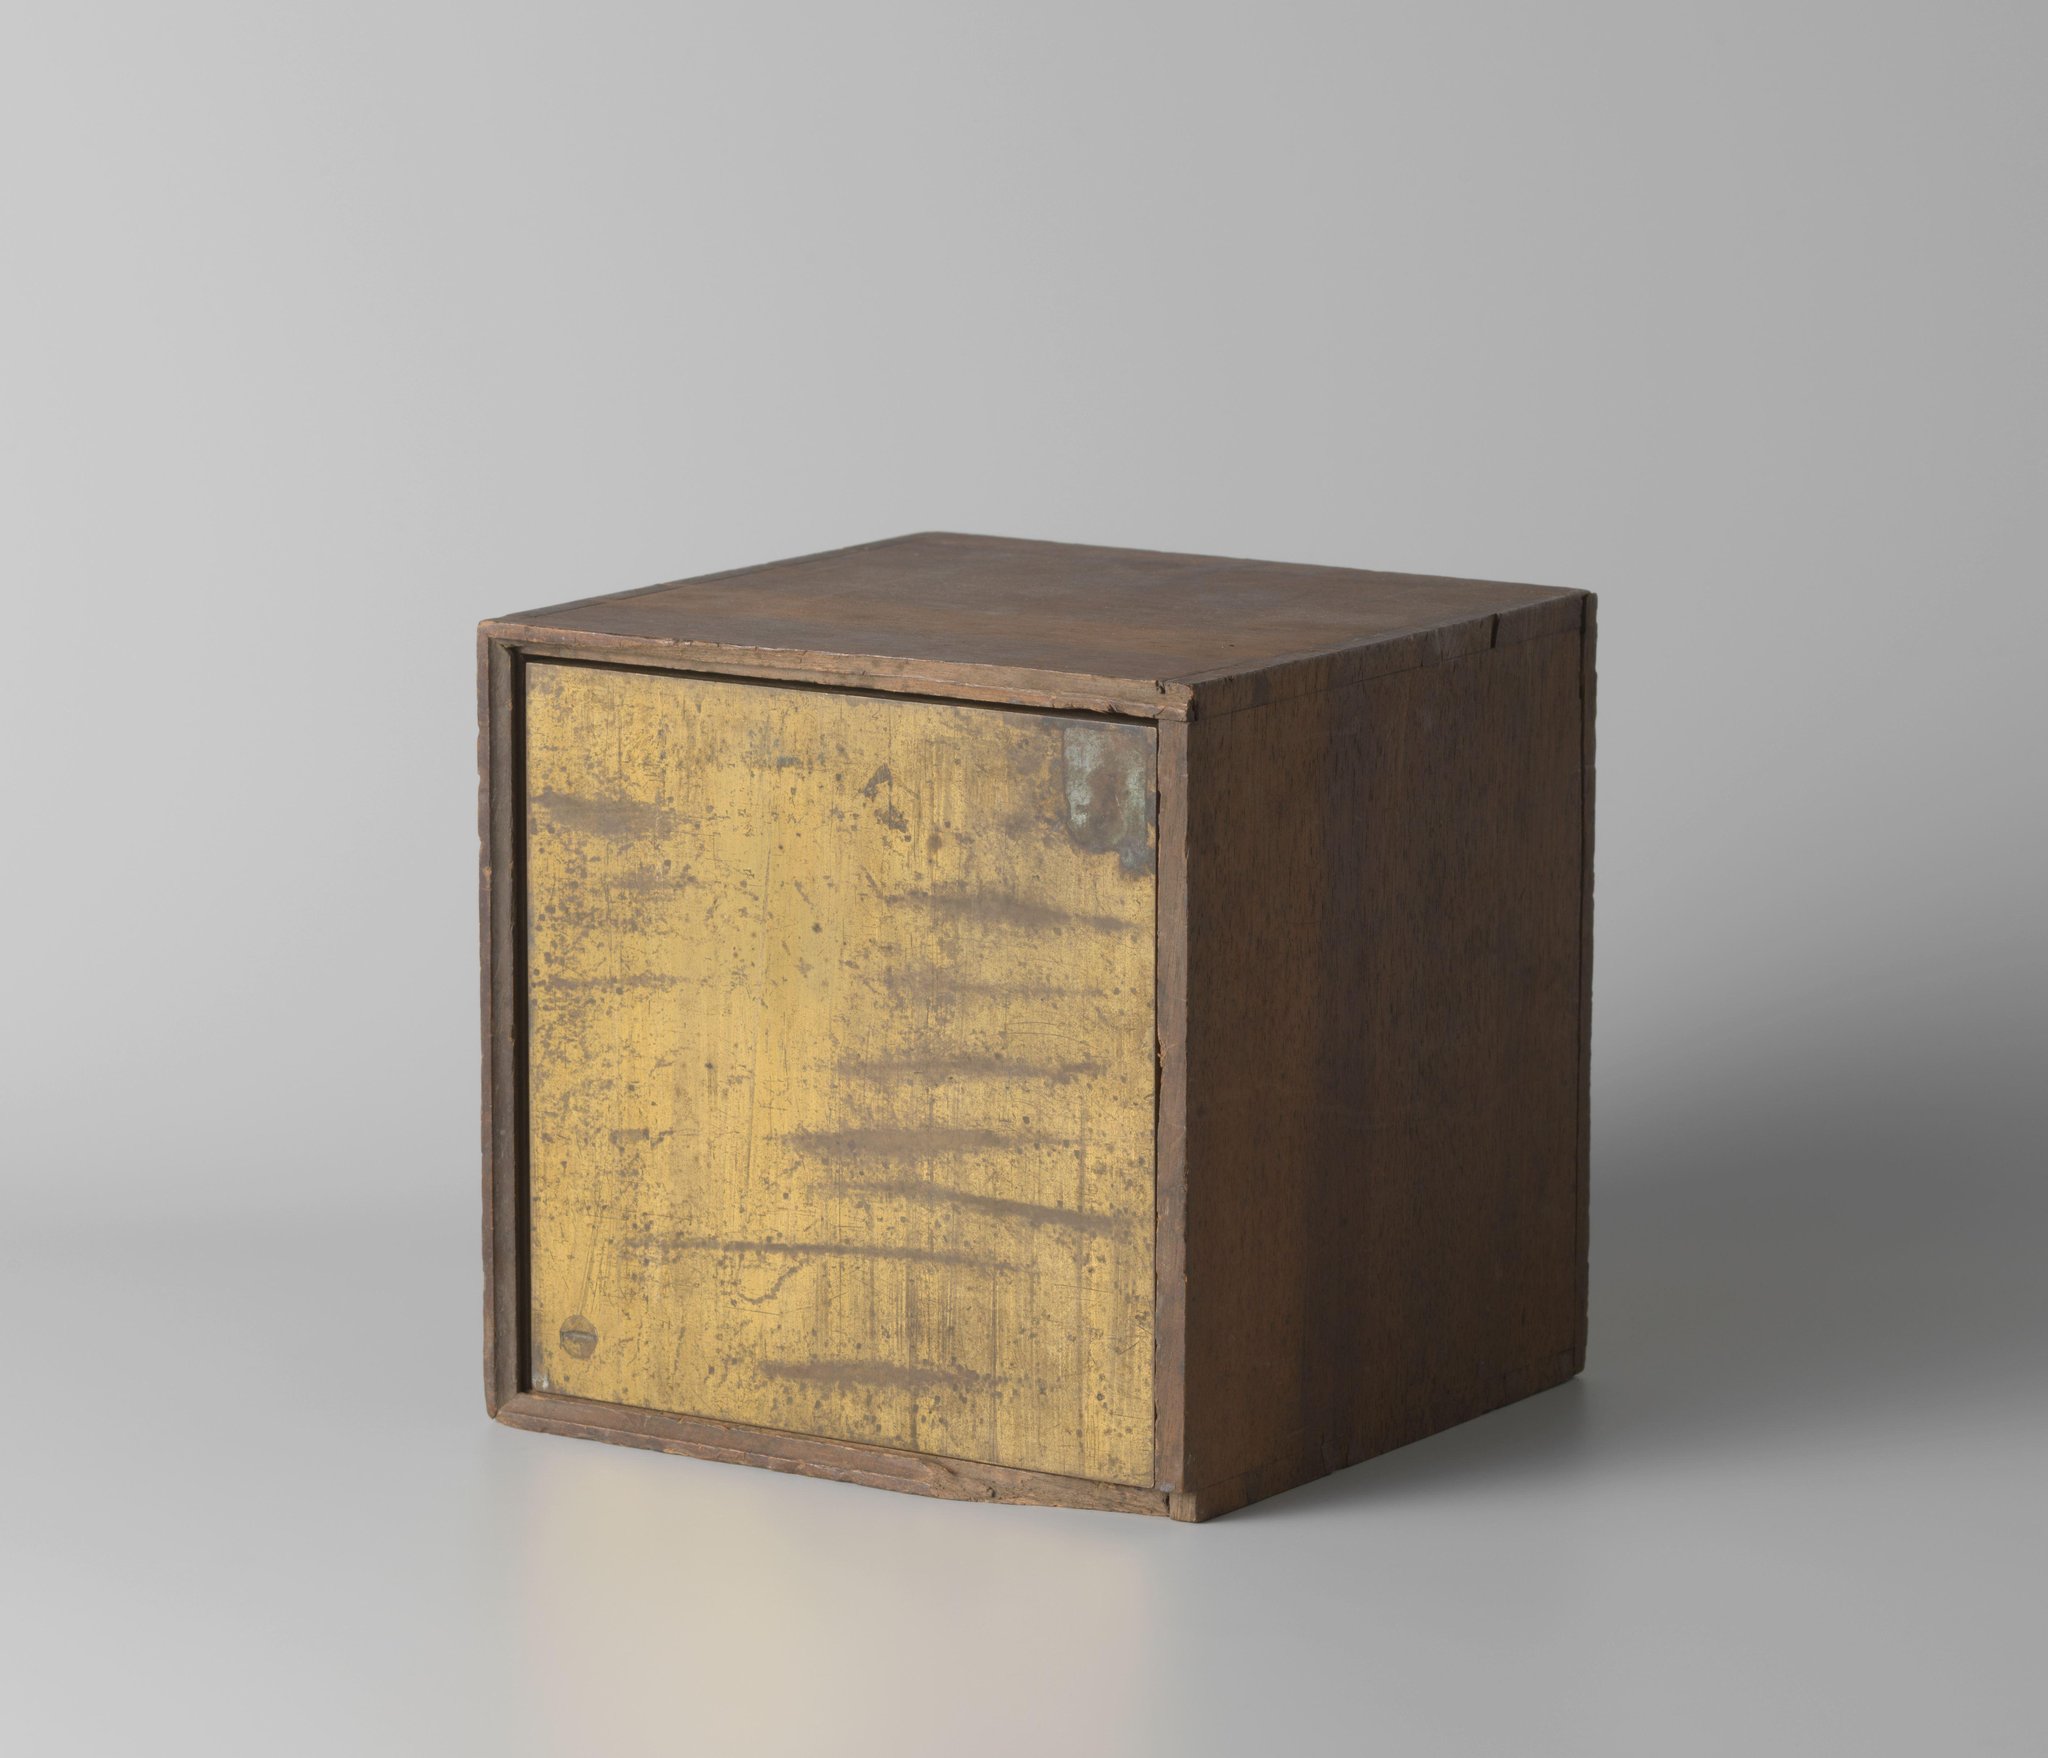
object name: chest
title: Kubus van koper, met hagel gevuld en in een houten kist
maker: Anonymous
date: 1400-1950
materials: copper, wood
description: Kubus van koper, met hagel gevuld en in een houten kist met een losse houten achterkant